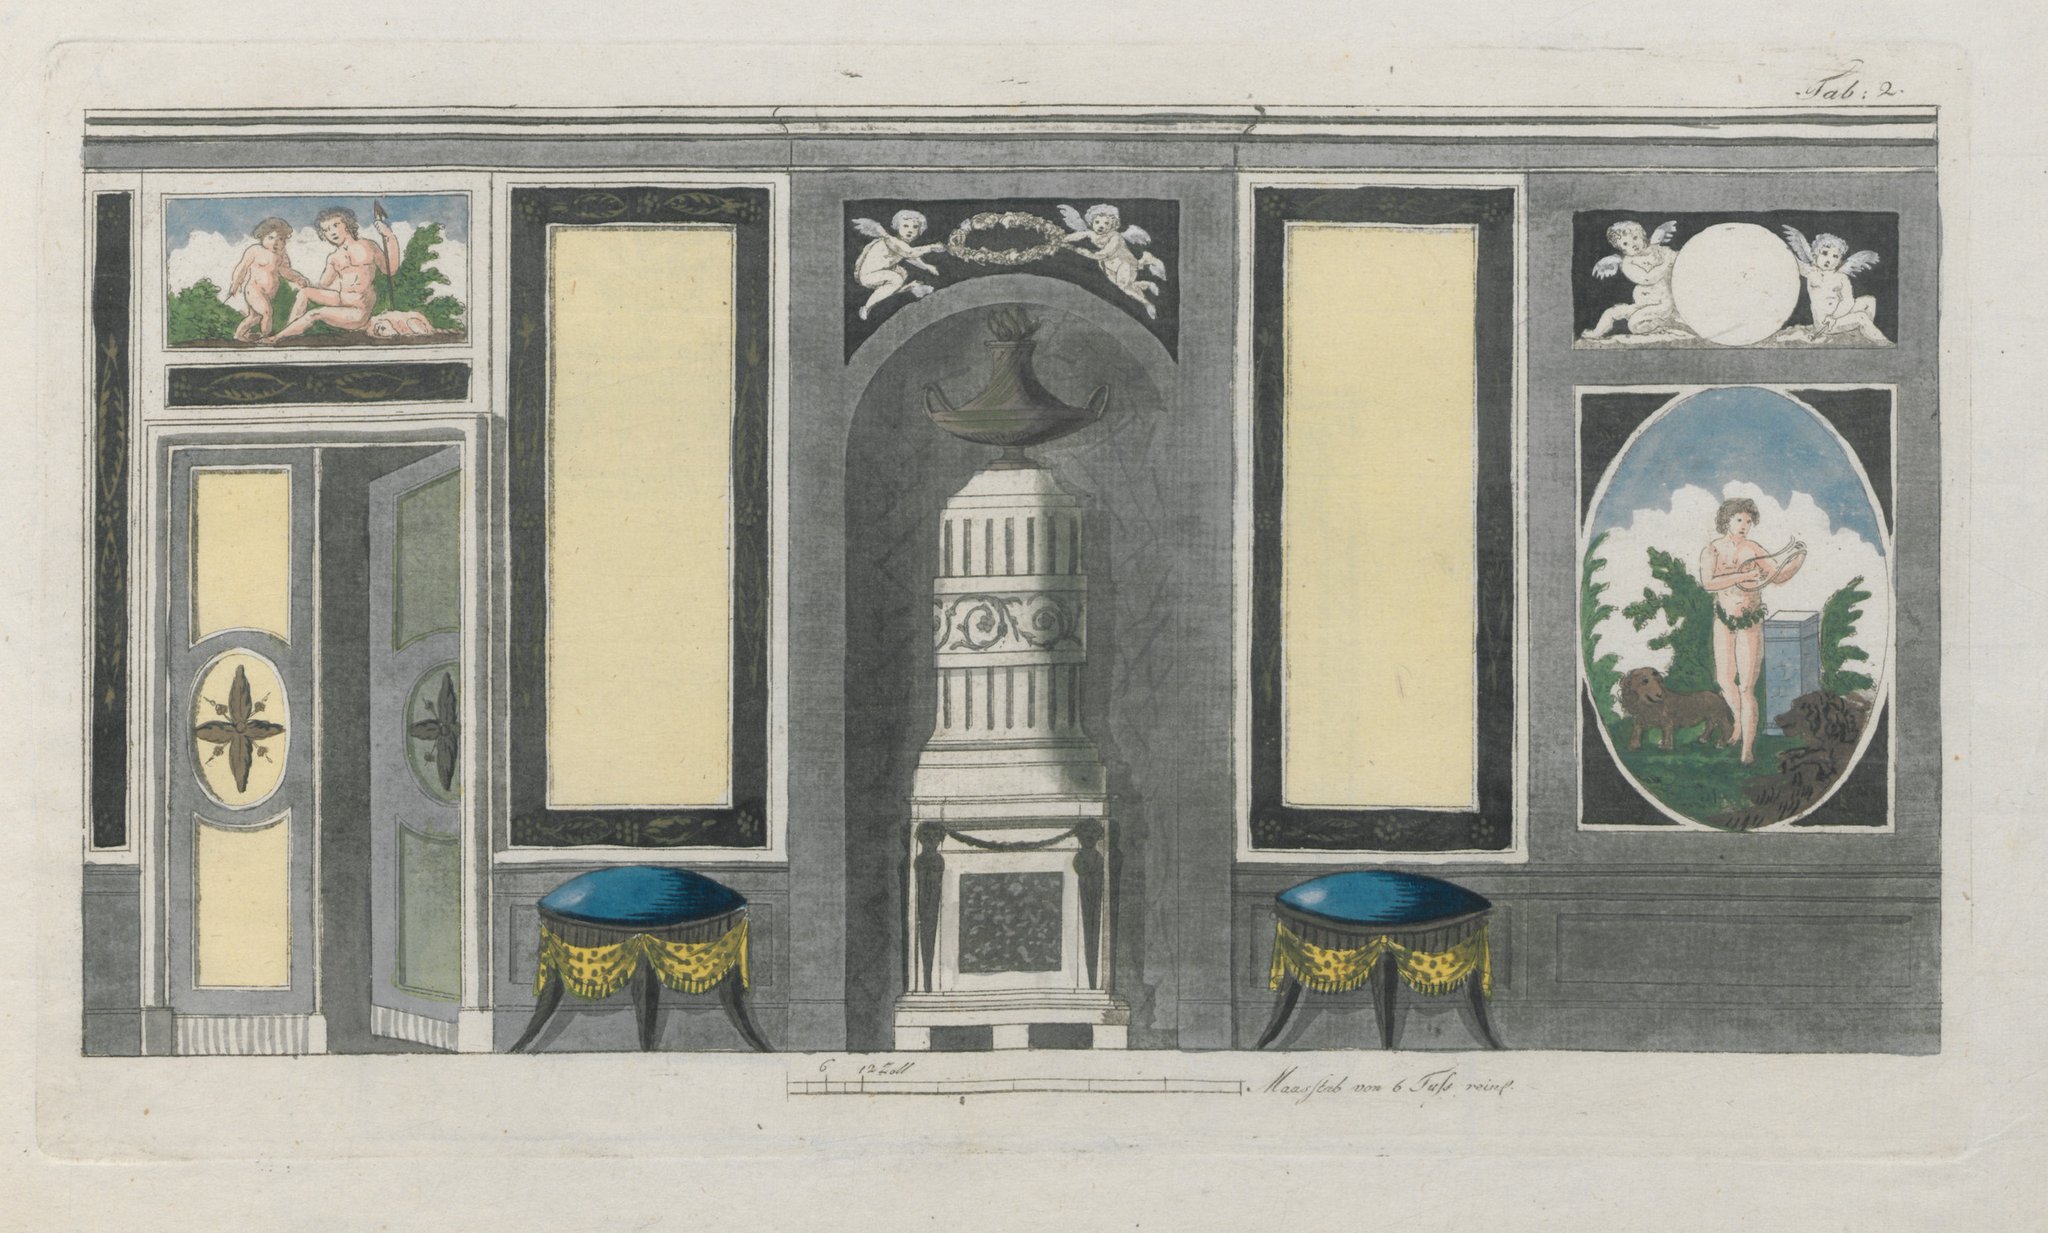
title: Muster zu Zimmer-Verzierungen und Ameublements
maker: voss und compagnie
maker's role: publisher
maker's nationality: german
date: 1794-1795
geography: germany